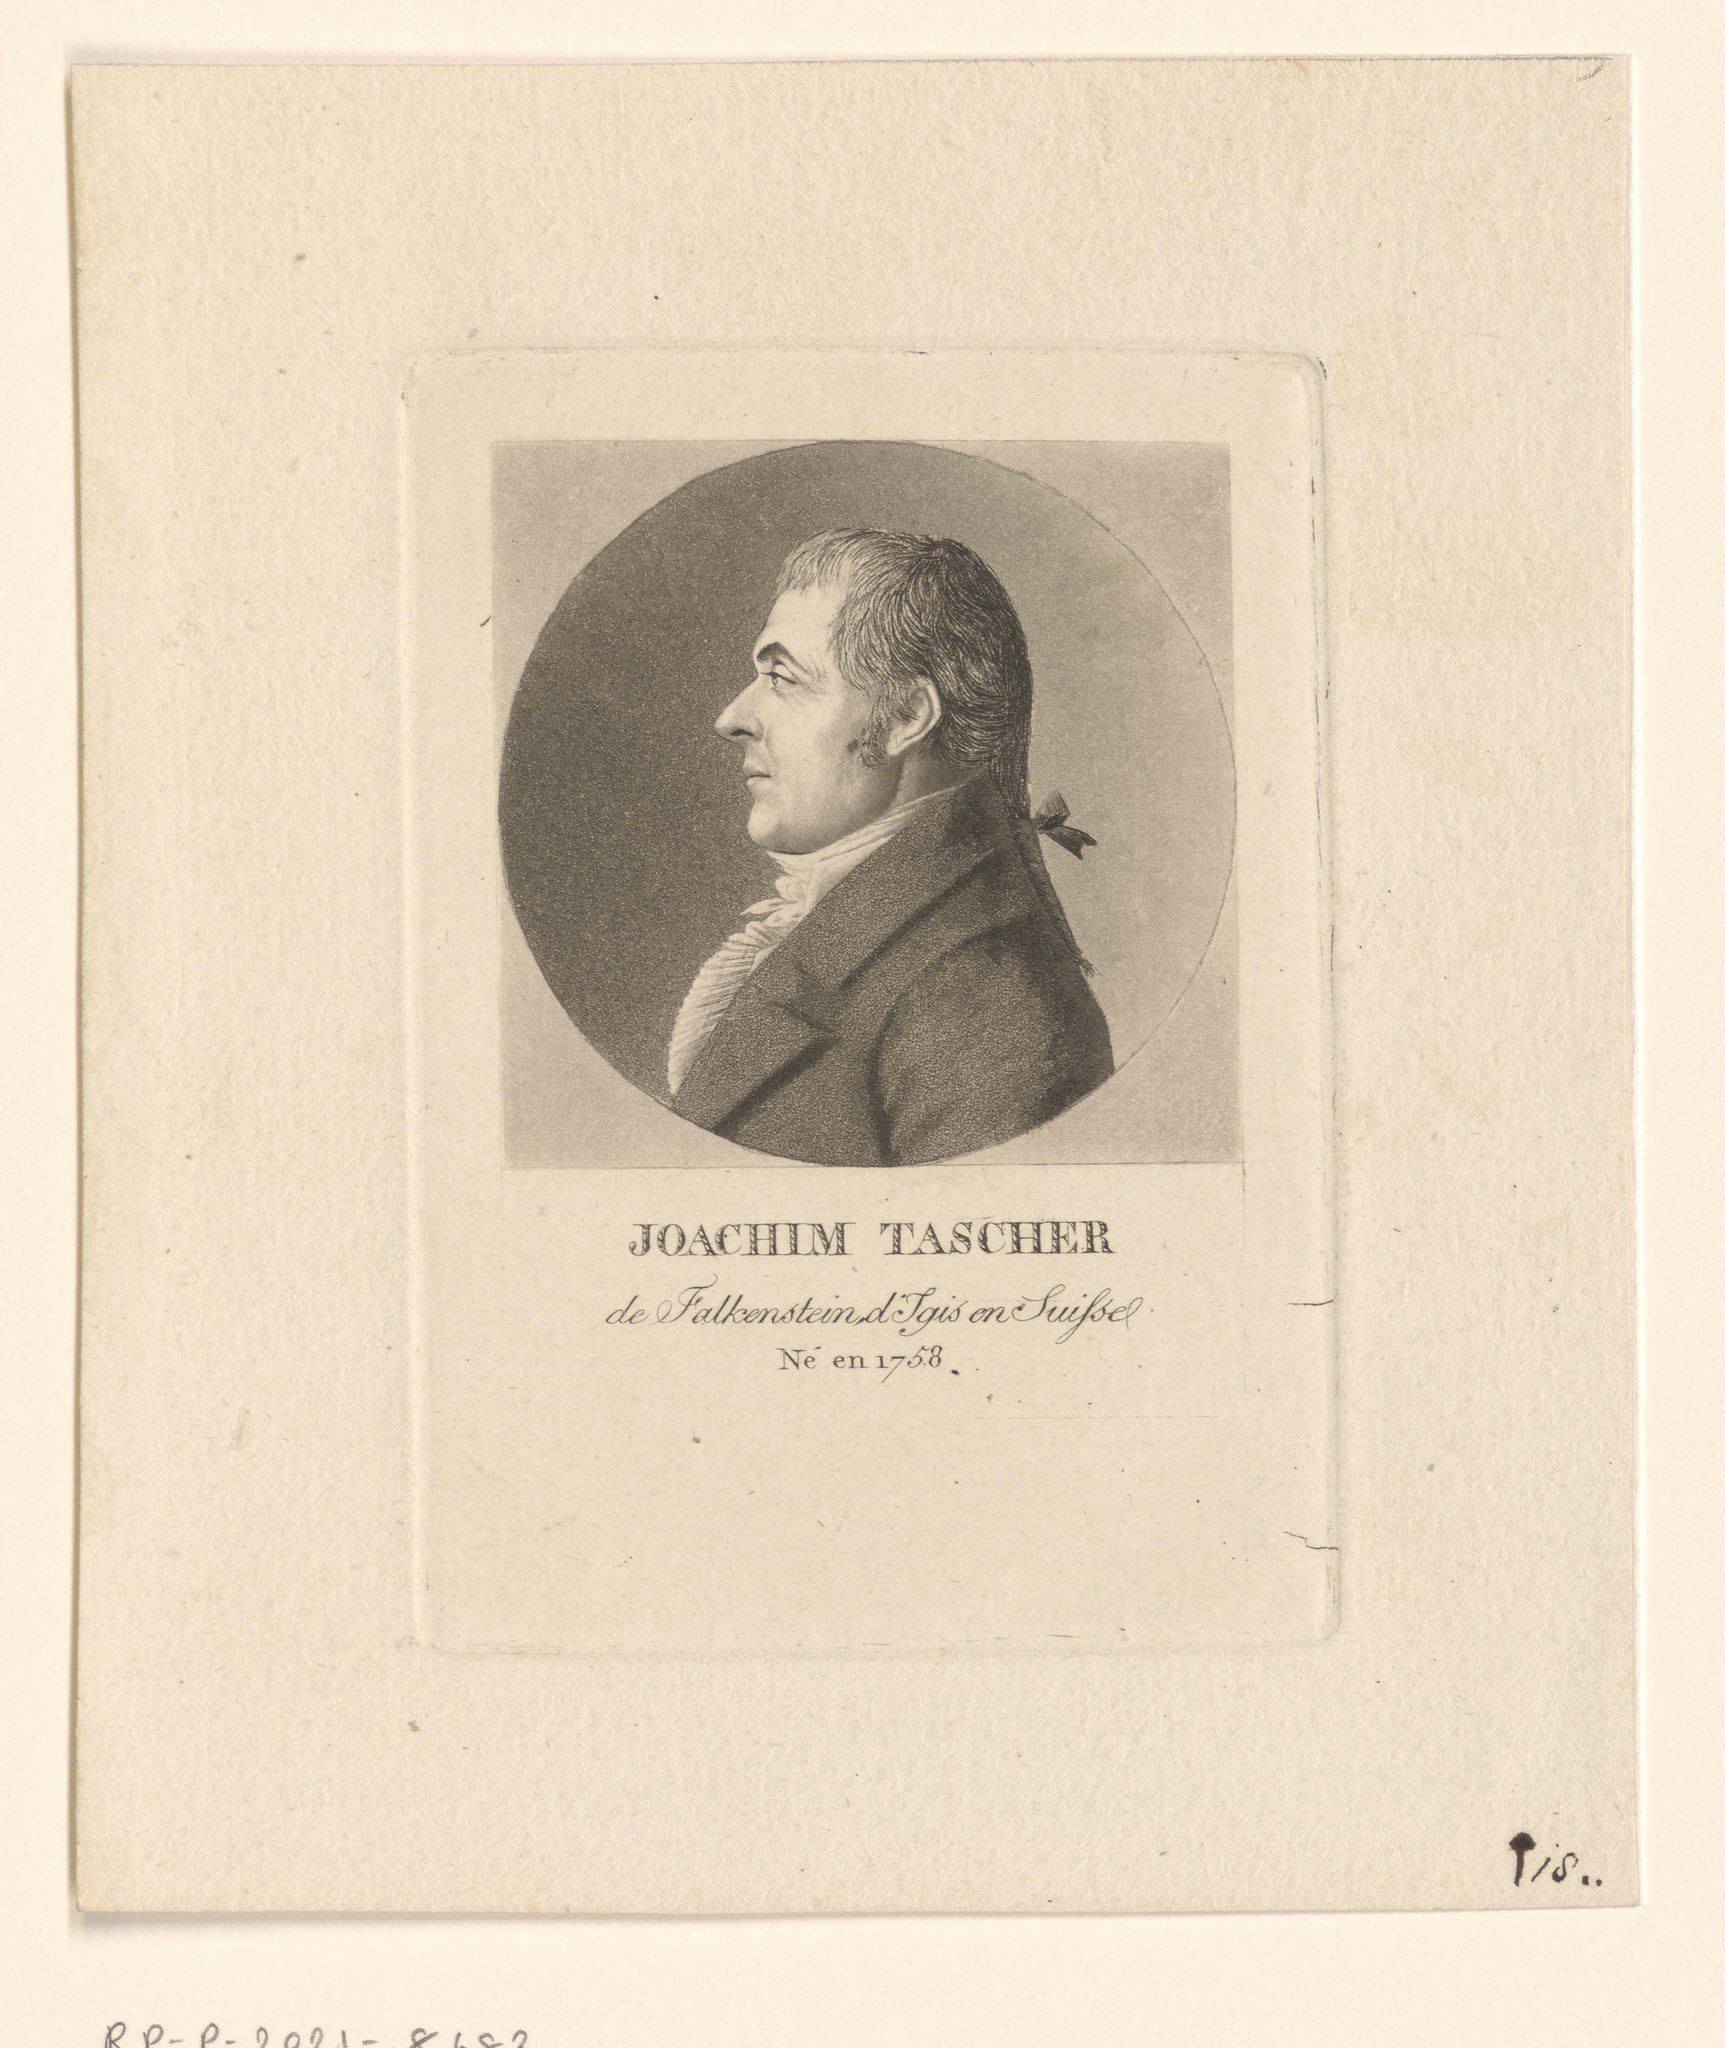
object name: print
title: Portret van Joachim Tascher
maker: Anonymous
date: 1790-1830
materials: paper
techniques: engraving, etching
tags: historical persons